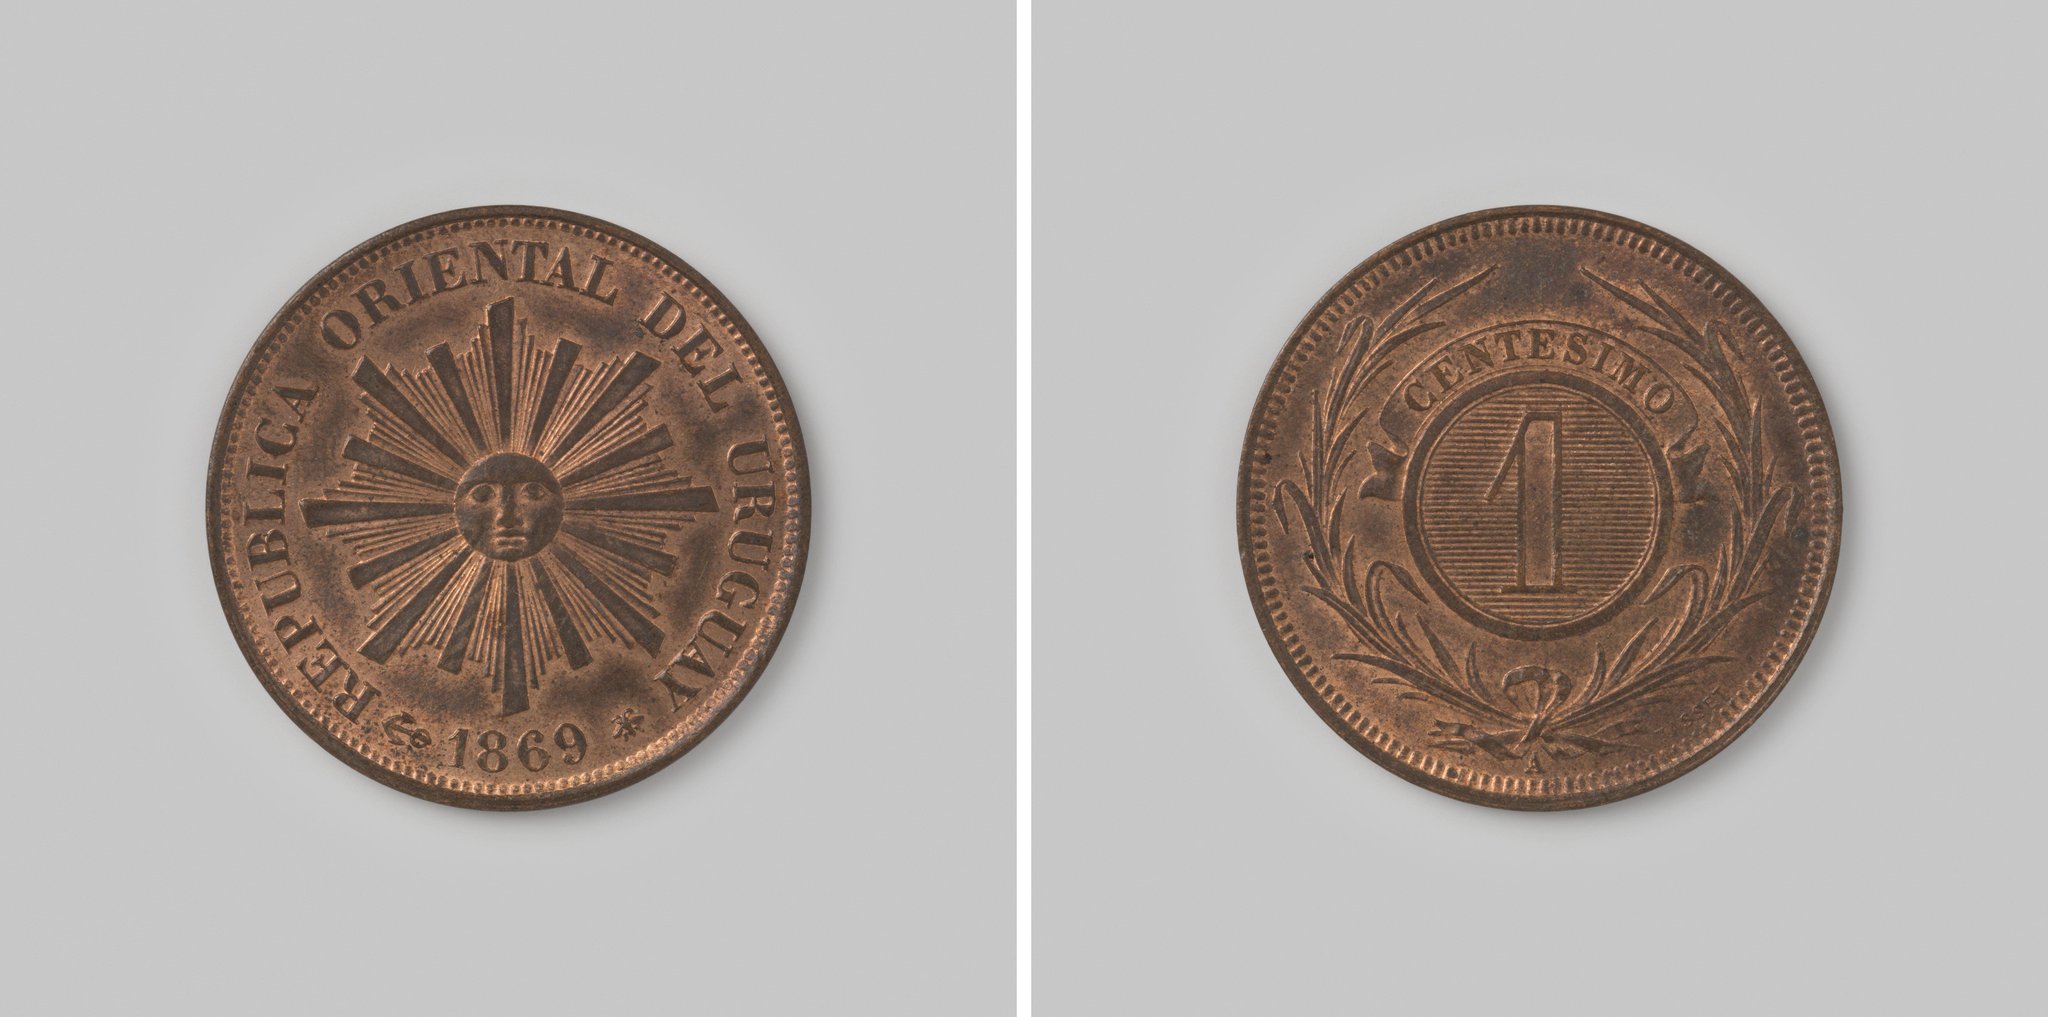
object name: coin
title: Centesimo uit Uruguay, 1869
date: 1869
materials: copper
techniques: striking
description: Koperen munt. Voorzijde: door grote en kleine stralen omgeven zon, waarin mensengezicht. Jaartal onderaan. Keerzijde: tussen twee samengebonden takken in twee regels waarde-aanduiding: centesimo 1 in twee regels. Gladde rand.